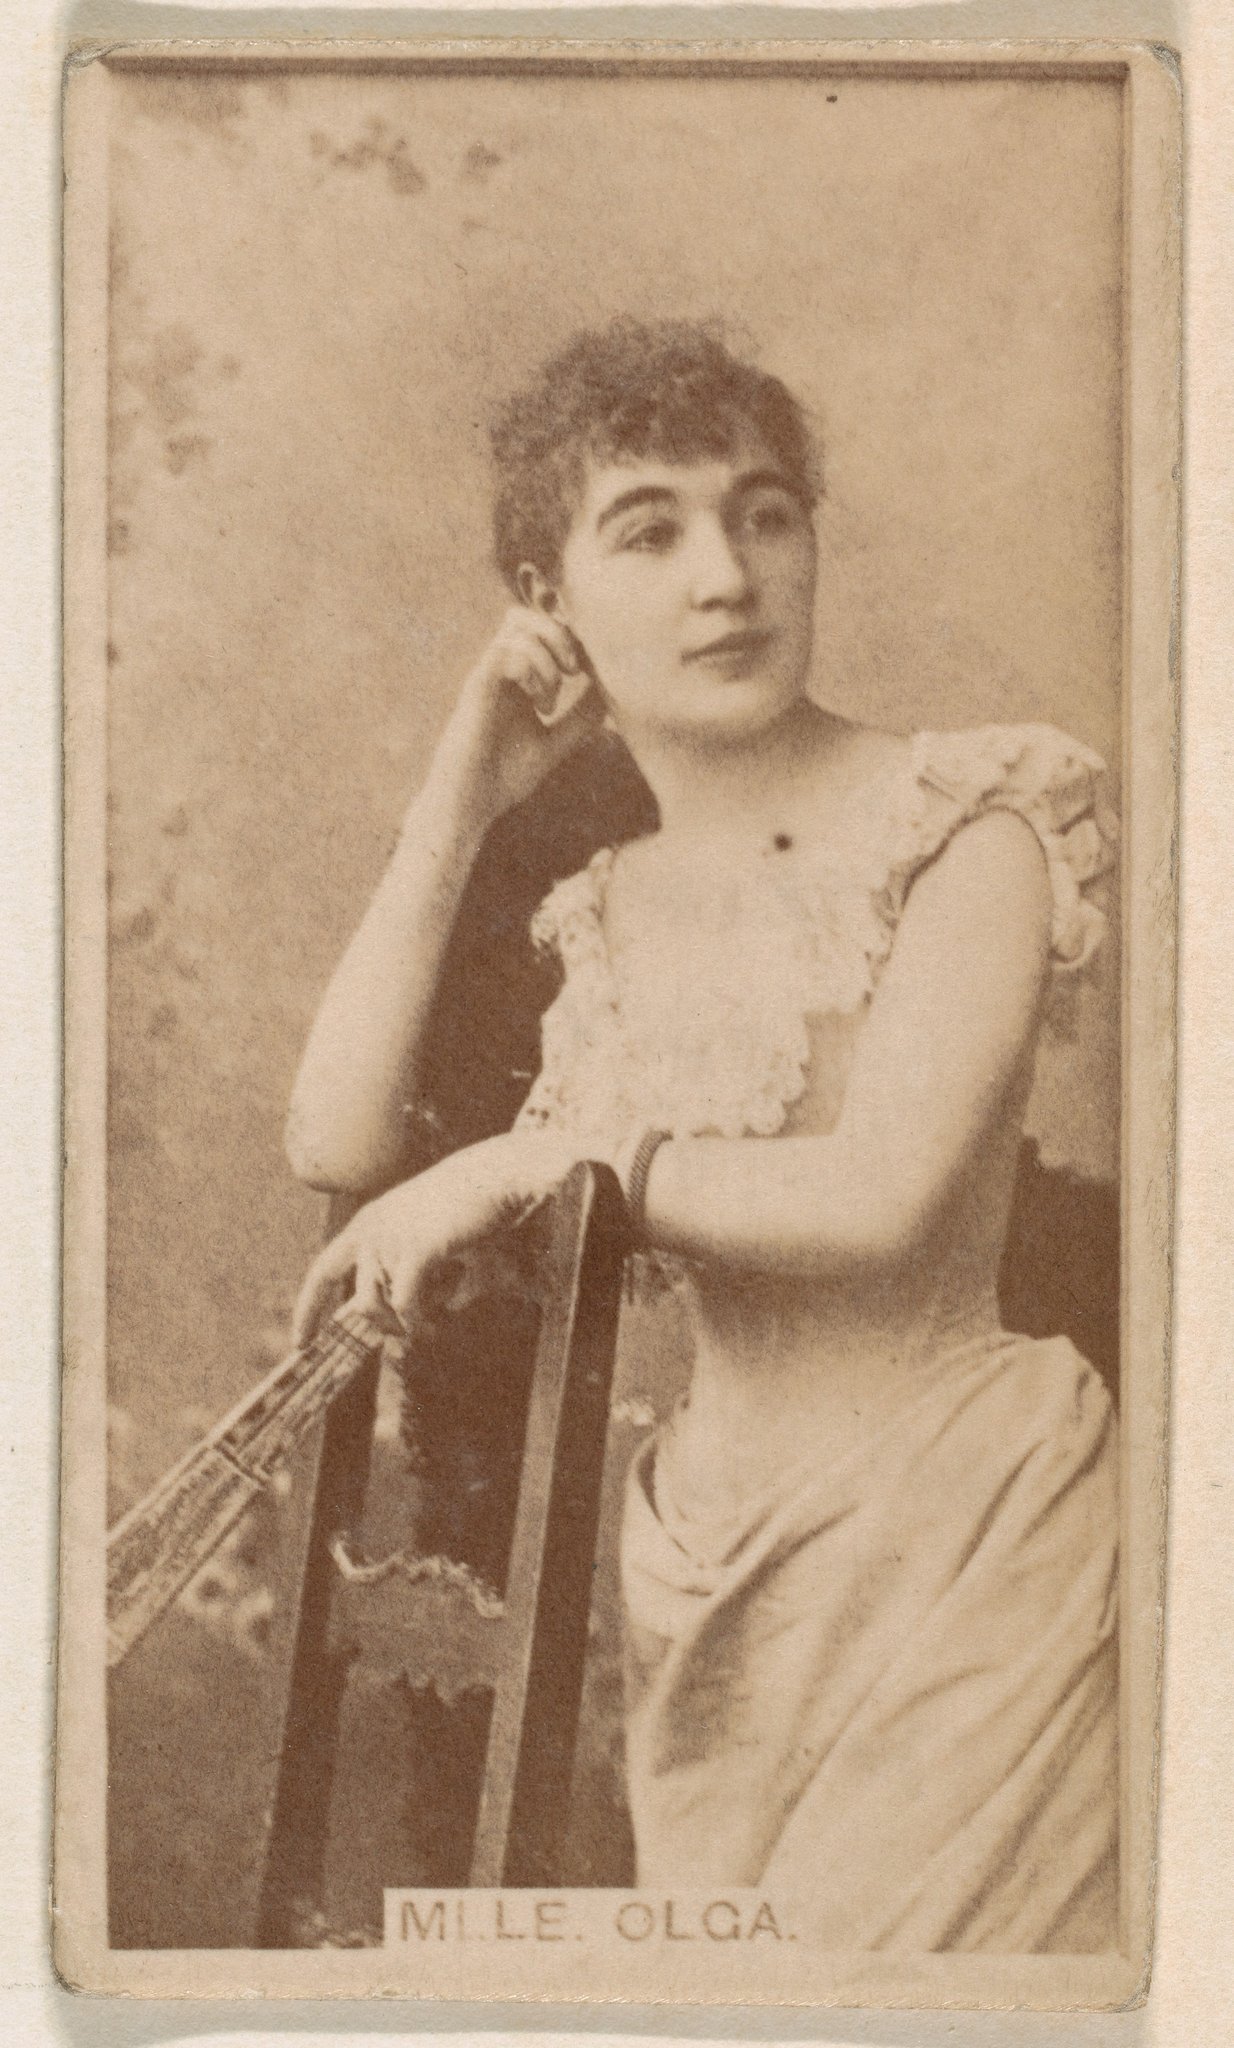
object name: photograph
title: Mlle. Olga, from the Actresses series (N245) issued by Kinney Brothers to promote Sweet Caporal Cigarettes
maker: kinney brothers tobacco company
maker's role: publisher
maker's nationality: american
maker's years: 1869-2011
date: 1890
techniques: albumen silver print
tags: portraits,women,actresses